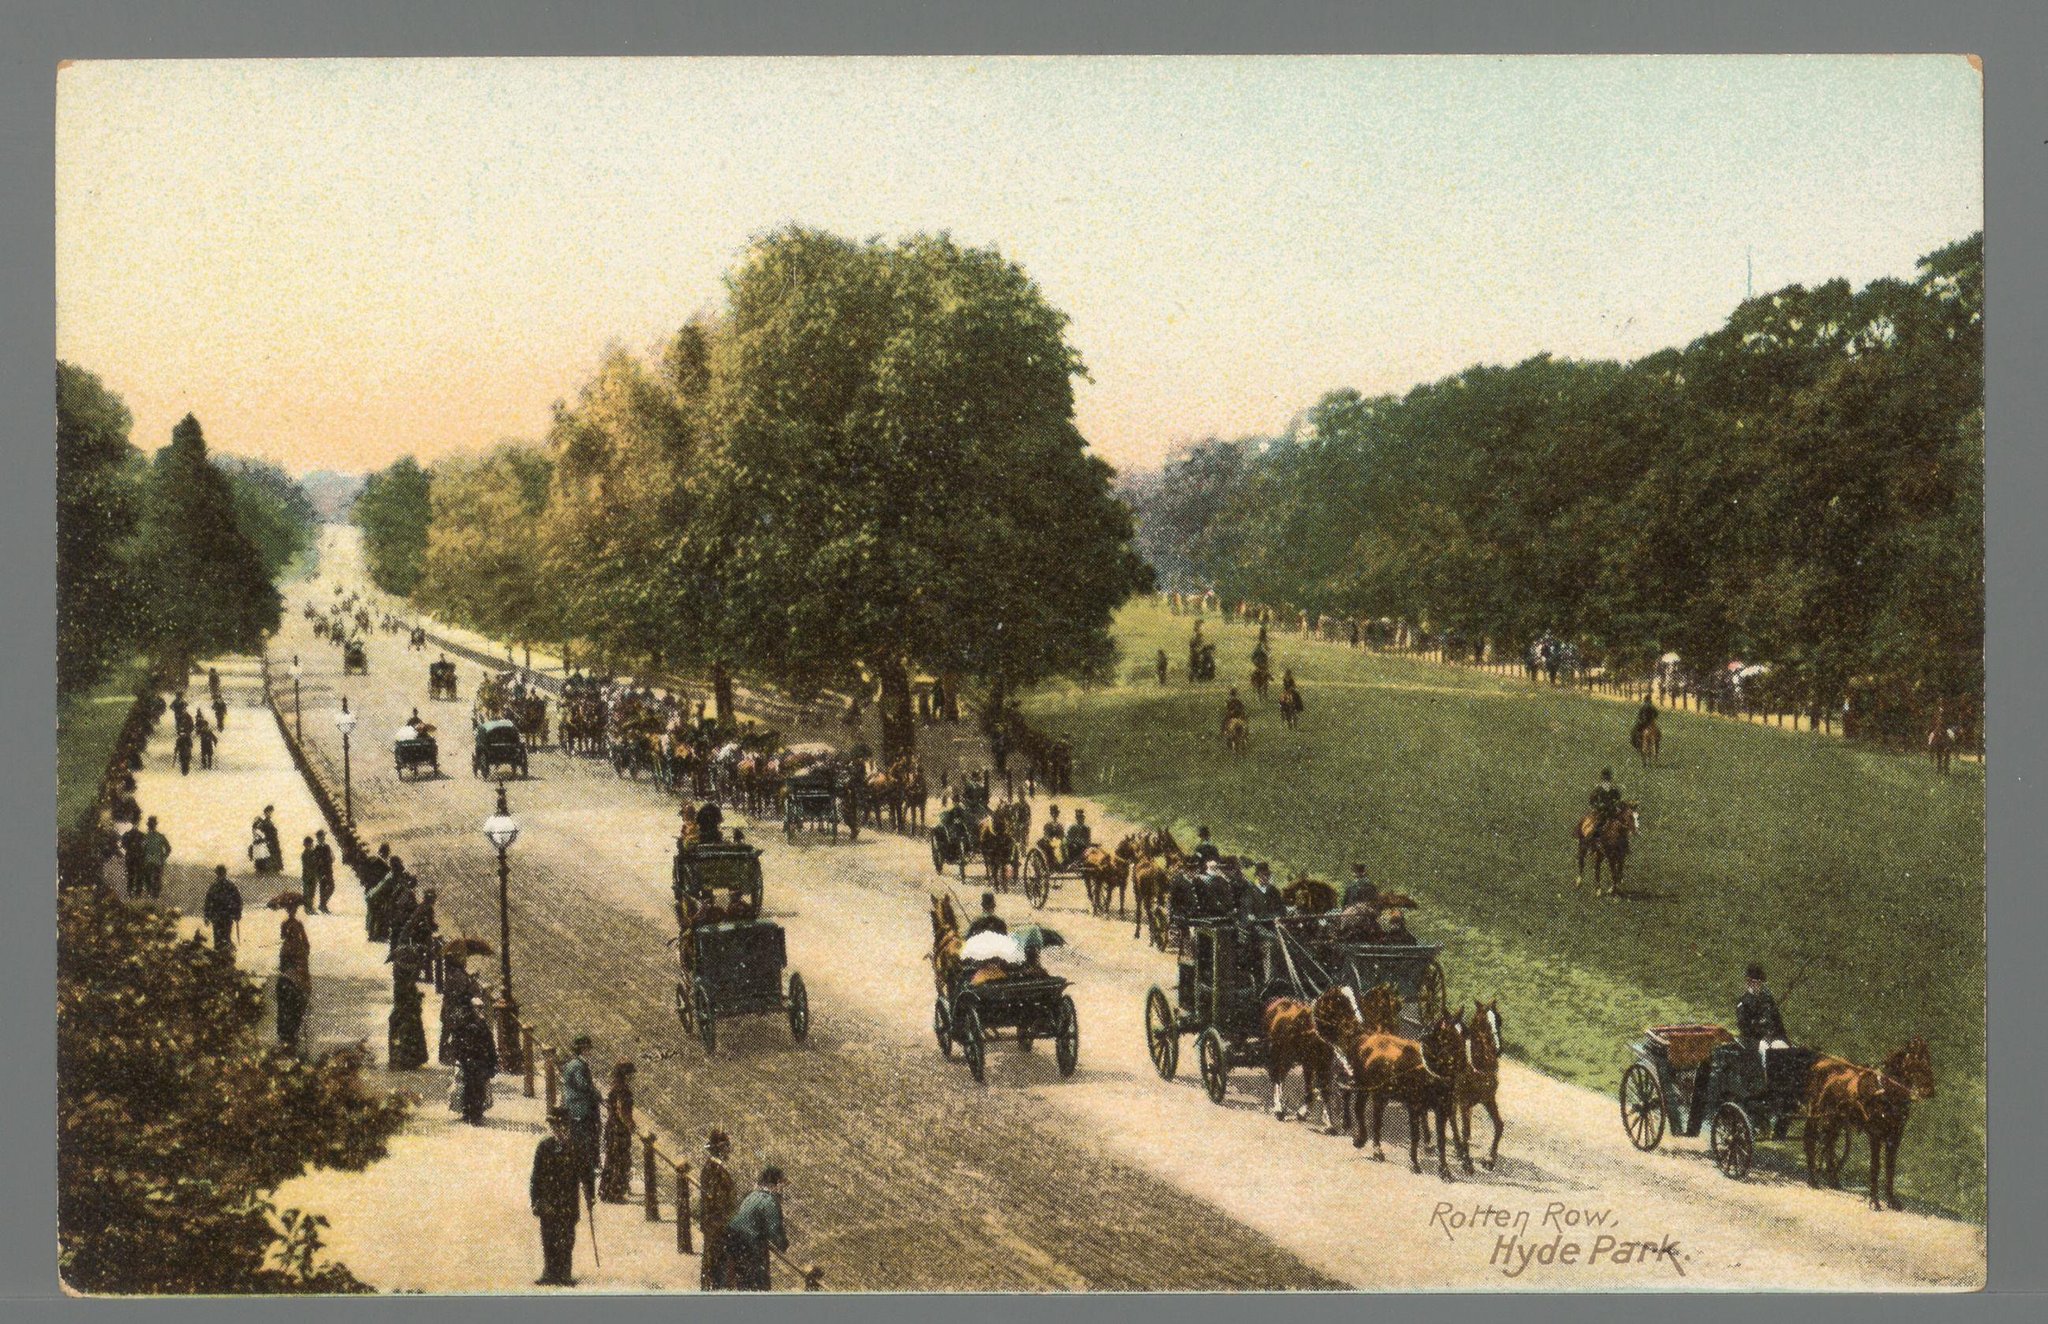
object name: ansichtkaart, prentbriefkaart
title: Rotten Row, Hyde Park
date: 1903-1916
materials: cardboard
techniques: lithograph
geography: london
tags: diligence, omnibus, horse-tram, park